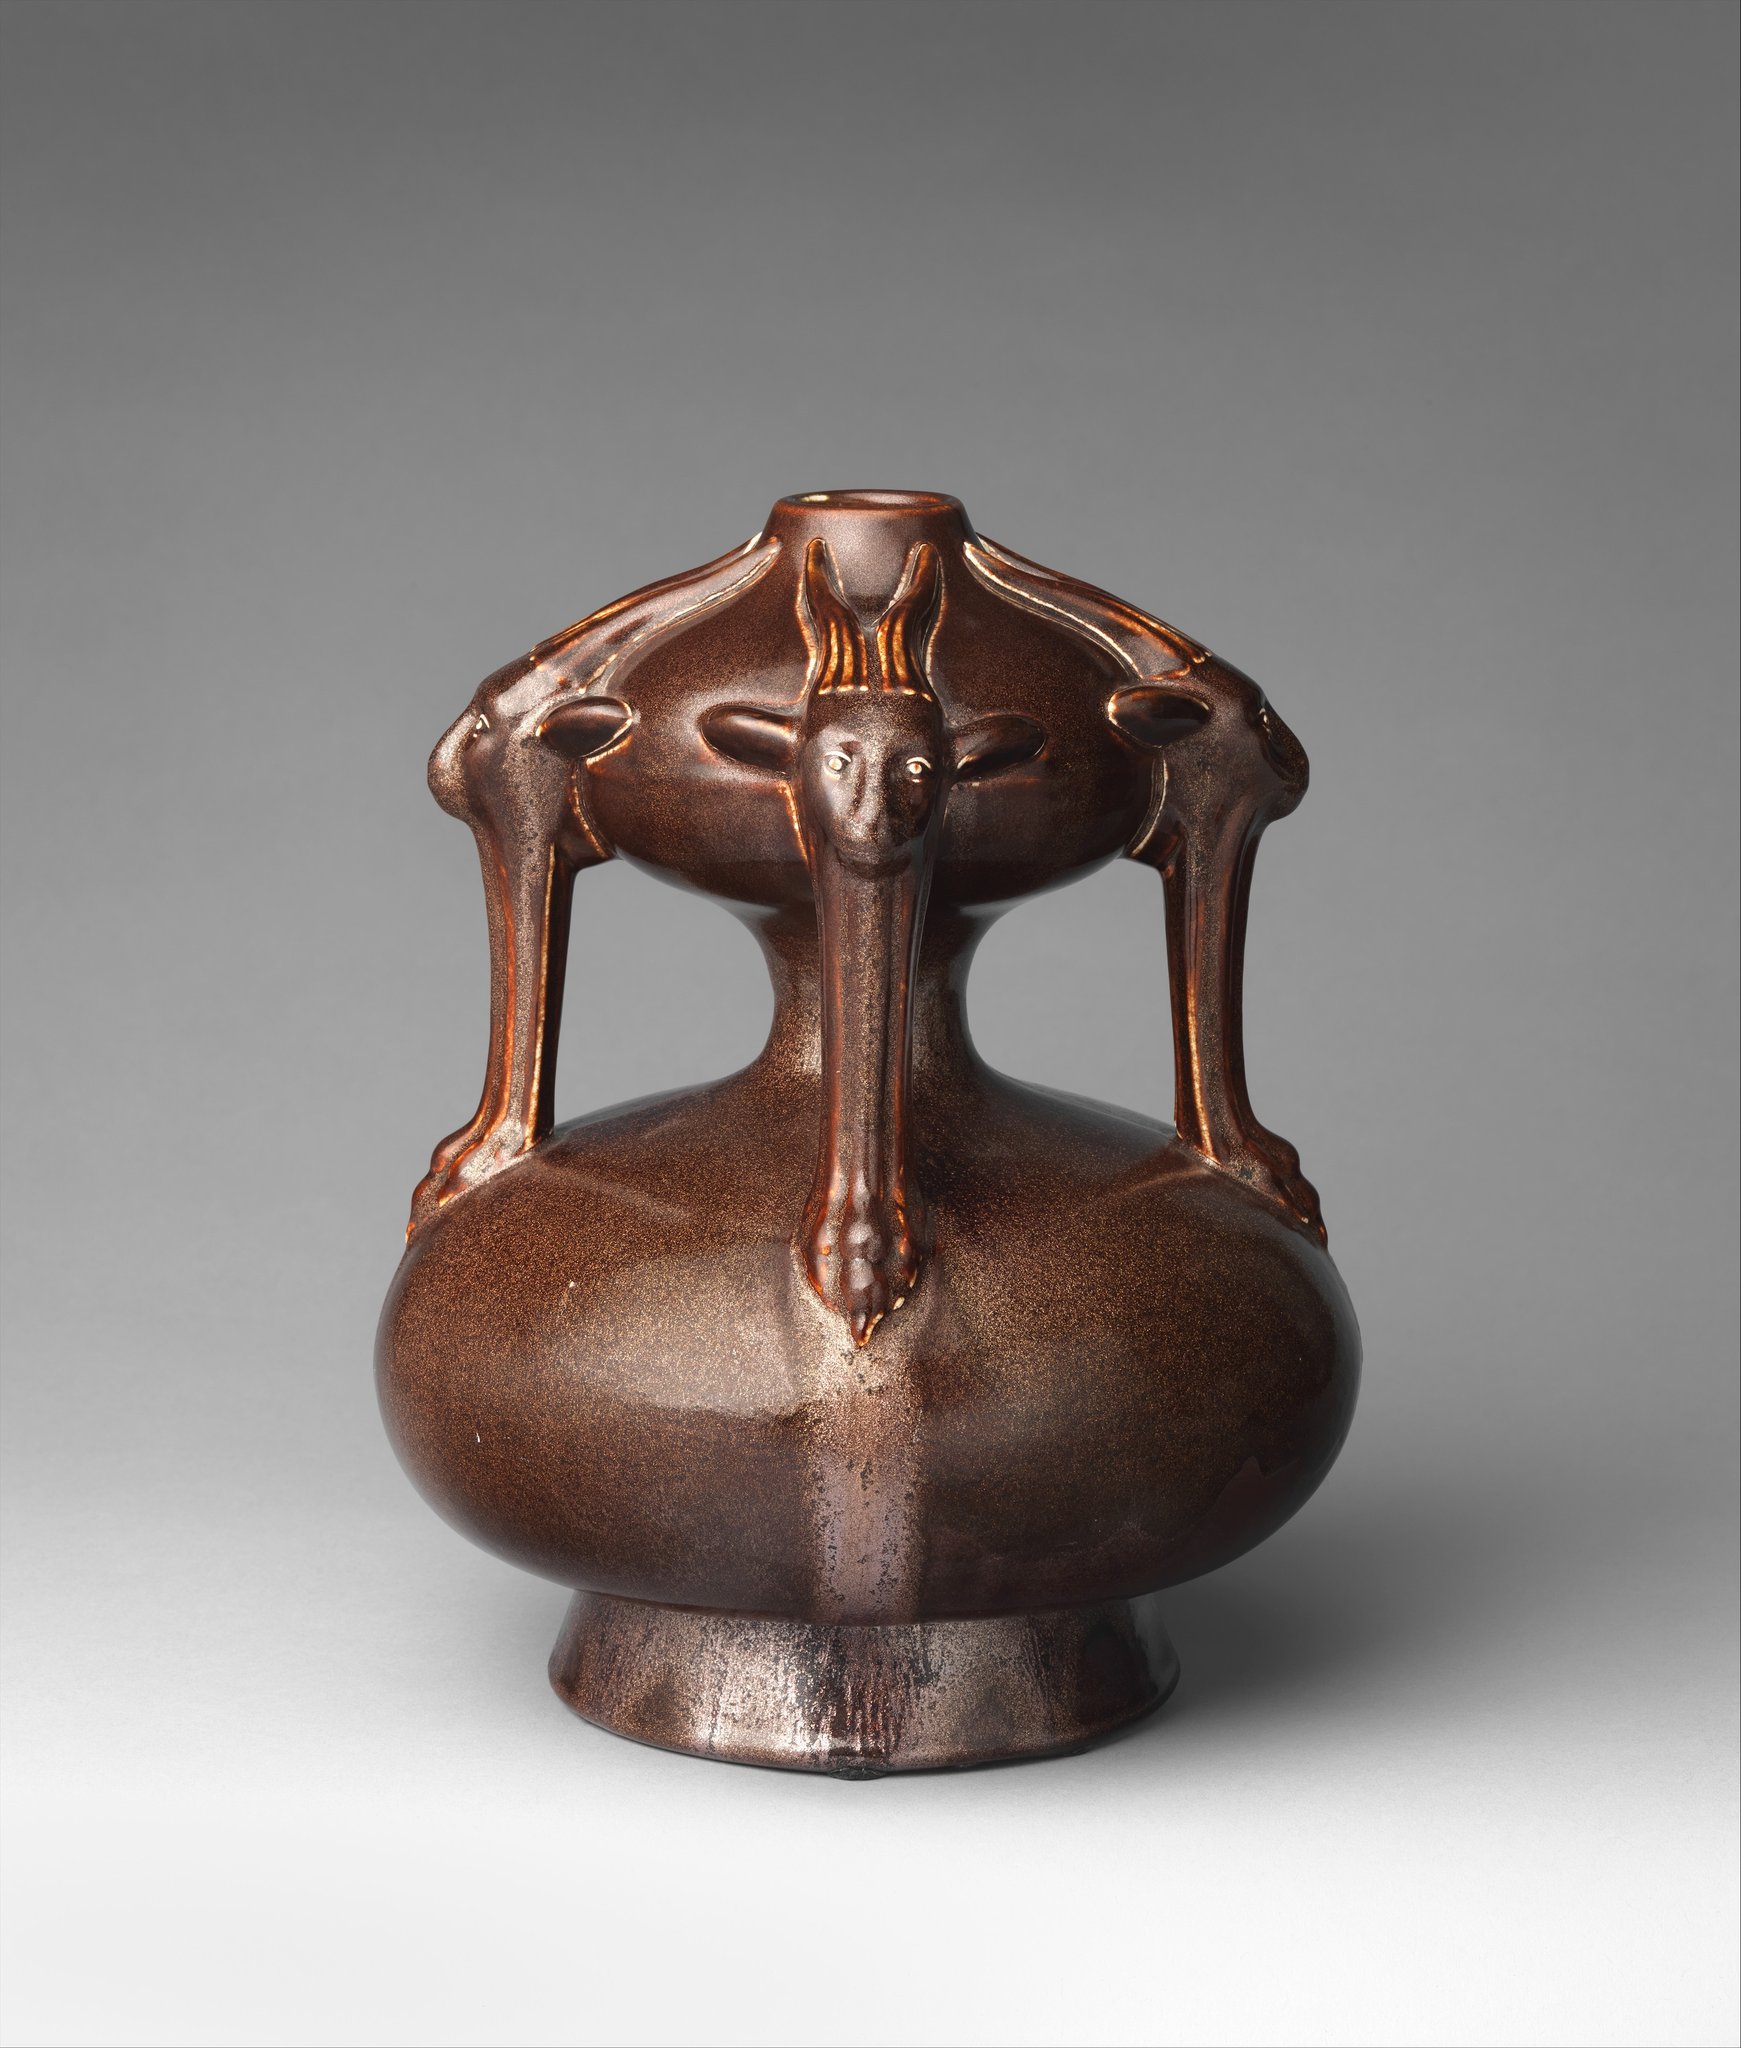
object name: vase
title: Vase with goat masks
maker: christopher dresser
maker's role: designer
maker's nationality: british, scottish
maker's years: 1834-1904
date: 1894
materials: stoneware